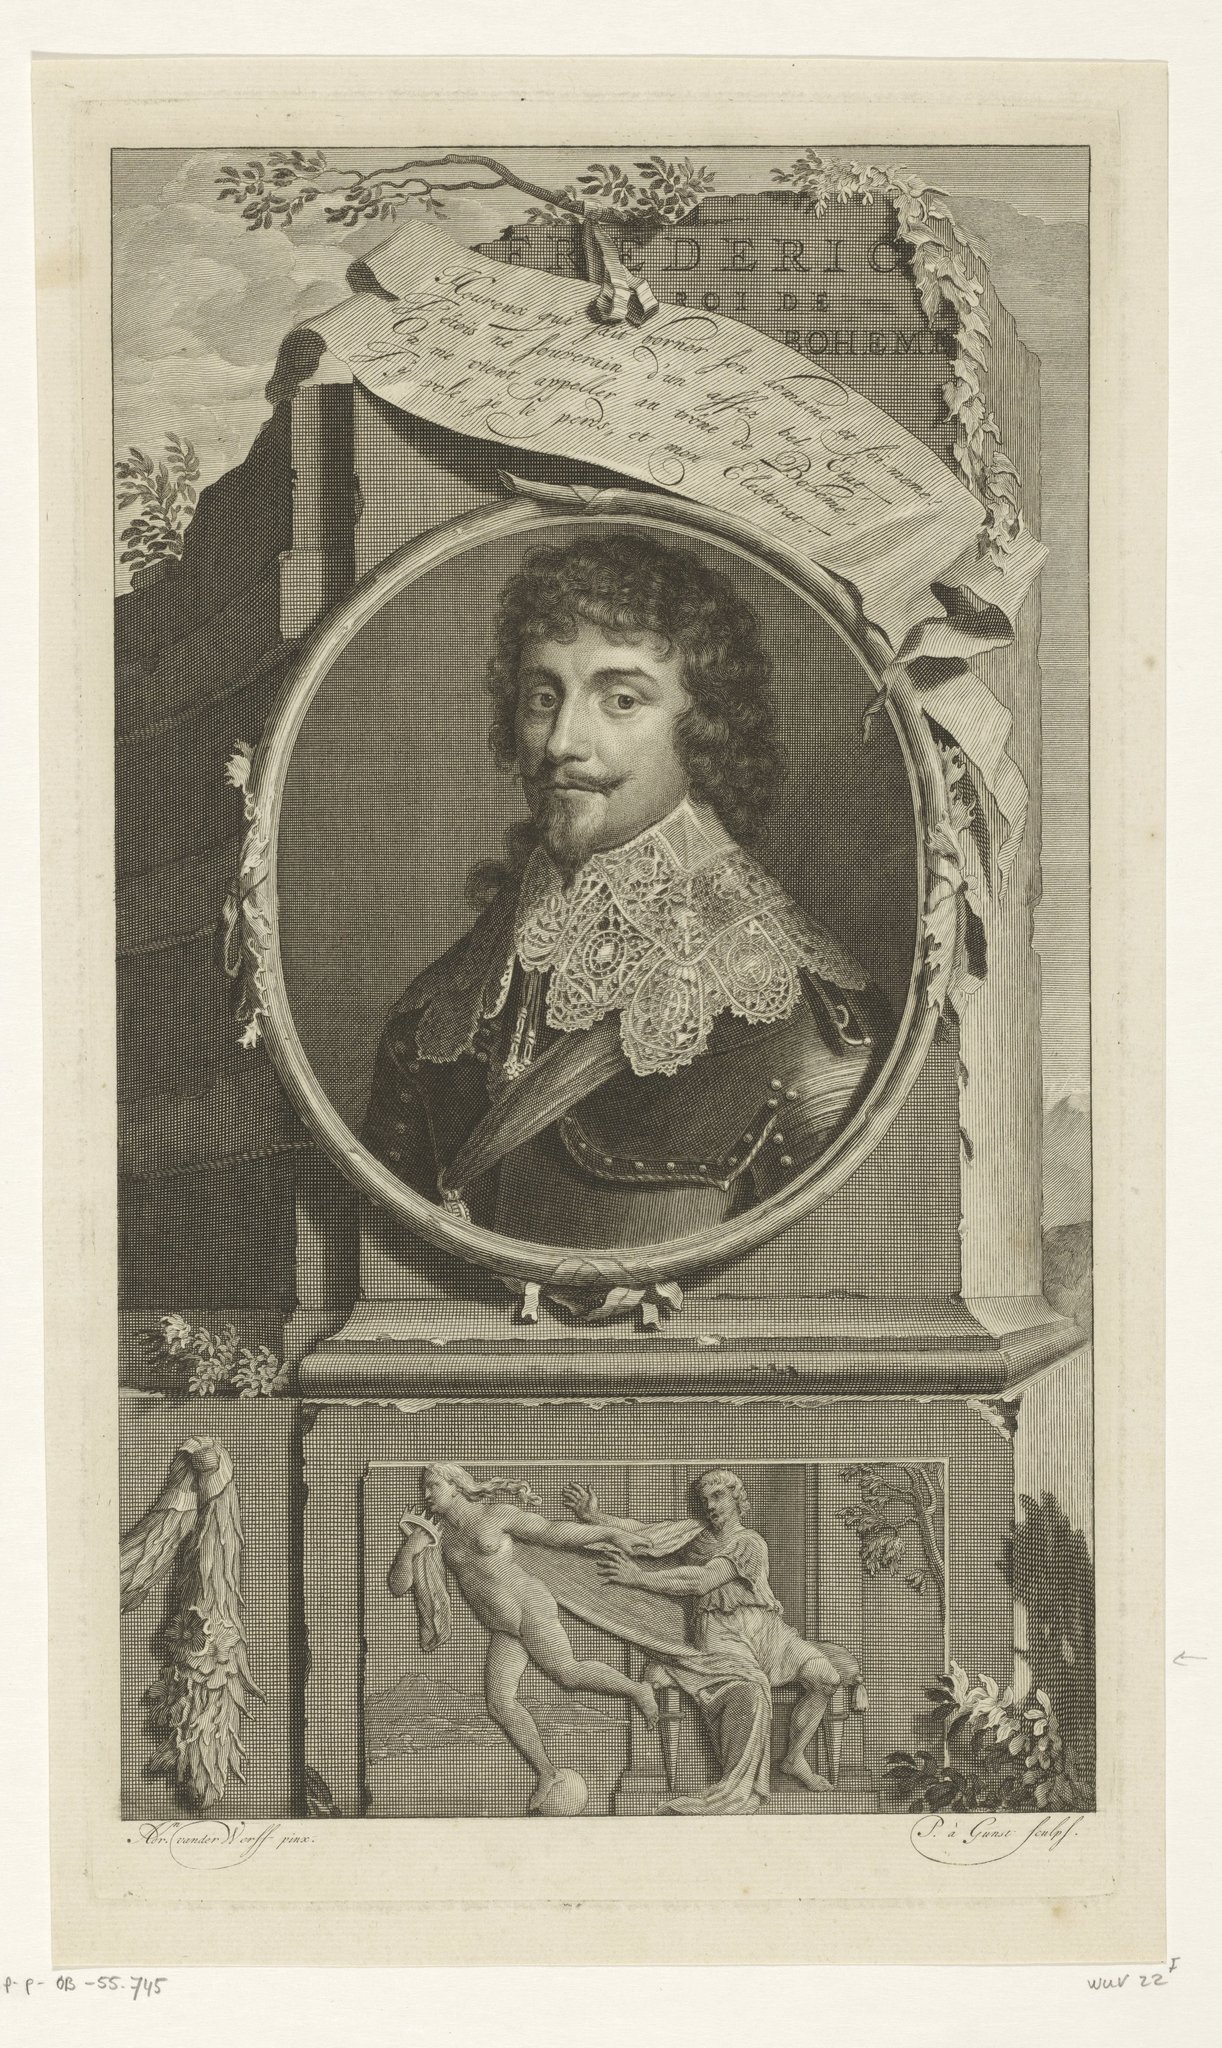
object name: print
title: Portret van Frederik V, keurvorst van de Palts, koning van Bohemen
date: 1669-1731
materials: paper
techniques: engraving, etching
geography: amsterdam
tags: amberg, frederik v (keurvorst van de palts, koning van bohemen), landscape with ruins, luck, fortune, lot; 'fato', 'fortuna', 'fortuna aurea', 'fortuna buona', 'fortuna pacifica overo clemente', 'sorte' (ripa)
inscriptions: collector's mark: Lugt 2228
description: Frederik V, keurvorst van de Palts, koning van Bohemen. Boven de prent een banderol met een Frans gedicht over zijn leven. Onder de prent een voorstelling van landschap met klassieke ruïnes met op de voorgrond de personificatie Fortuna die de kroon steelt van Frederik V.